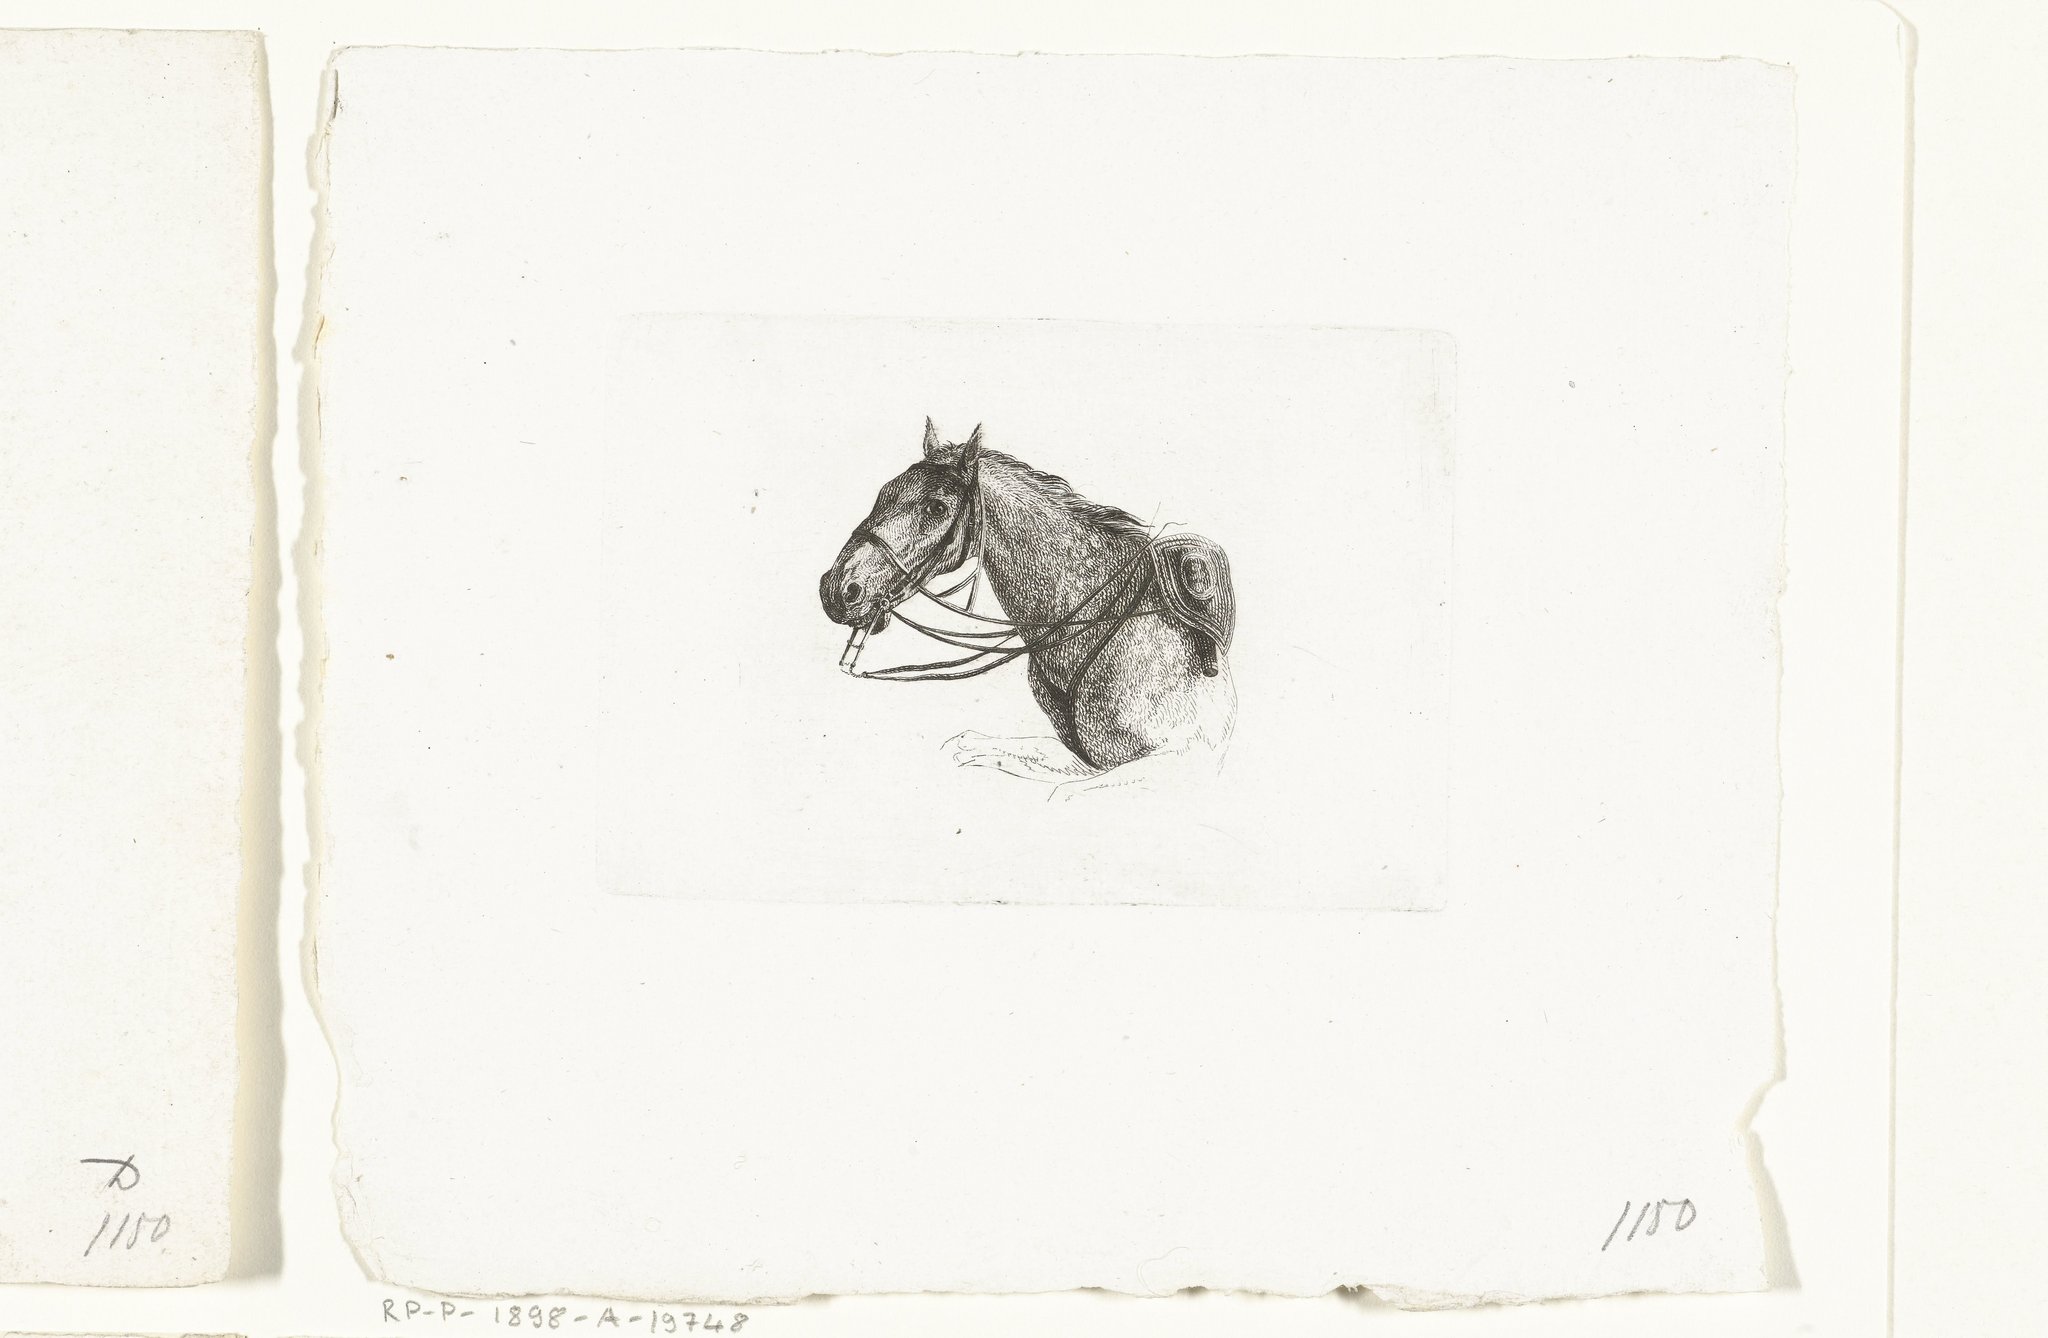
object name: print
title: Paardenhoofd, naar links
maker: joannes bemme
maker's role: print maker, printer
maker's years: 1775-1841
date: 1800-1841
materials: paper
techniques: etching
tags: horse (+ head of an animal)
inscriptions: collector's mark: Lugt 2228